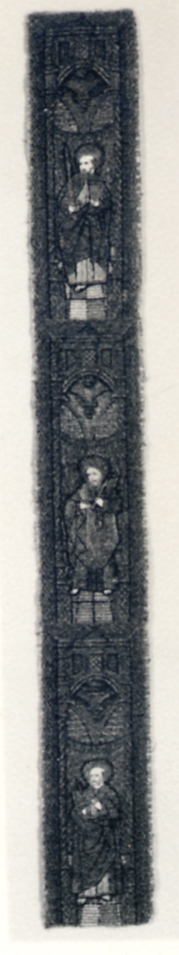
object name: orphrey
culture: german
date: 1500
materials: cotton, silk, wool